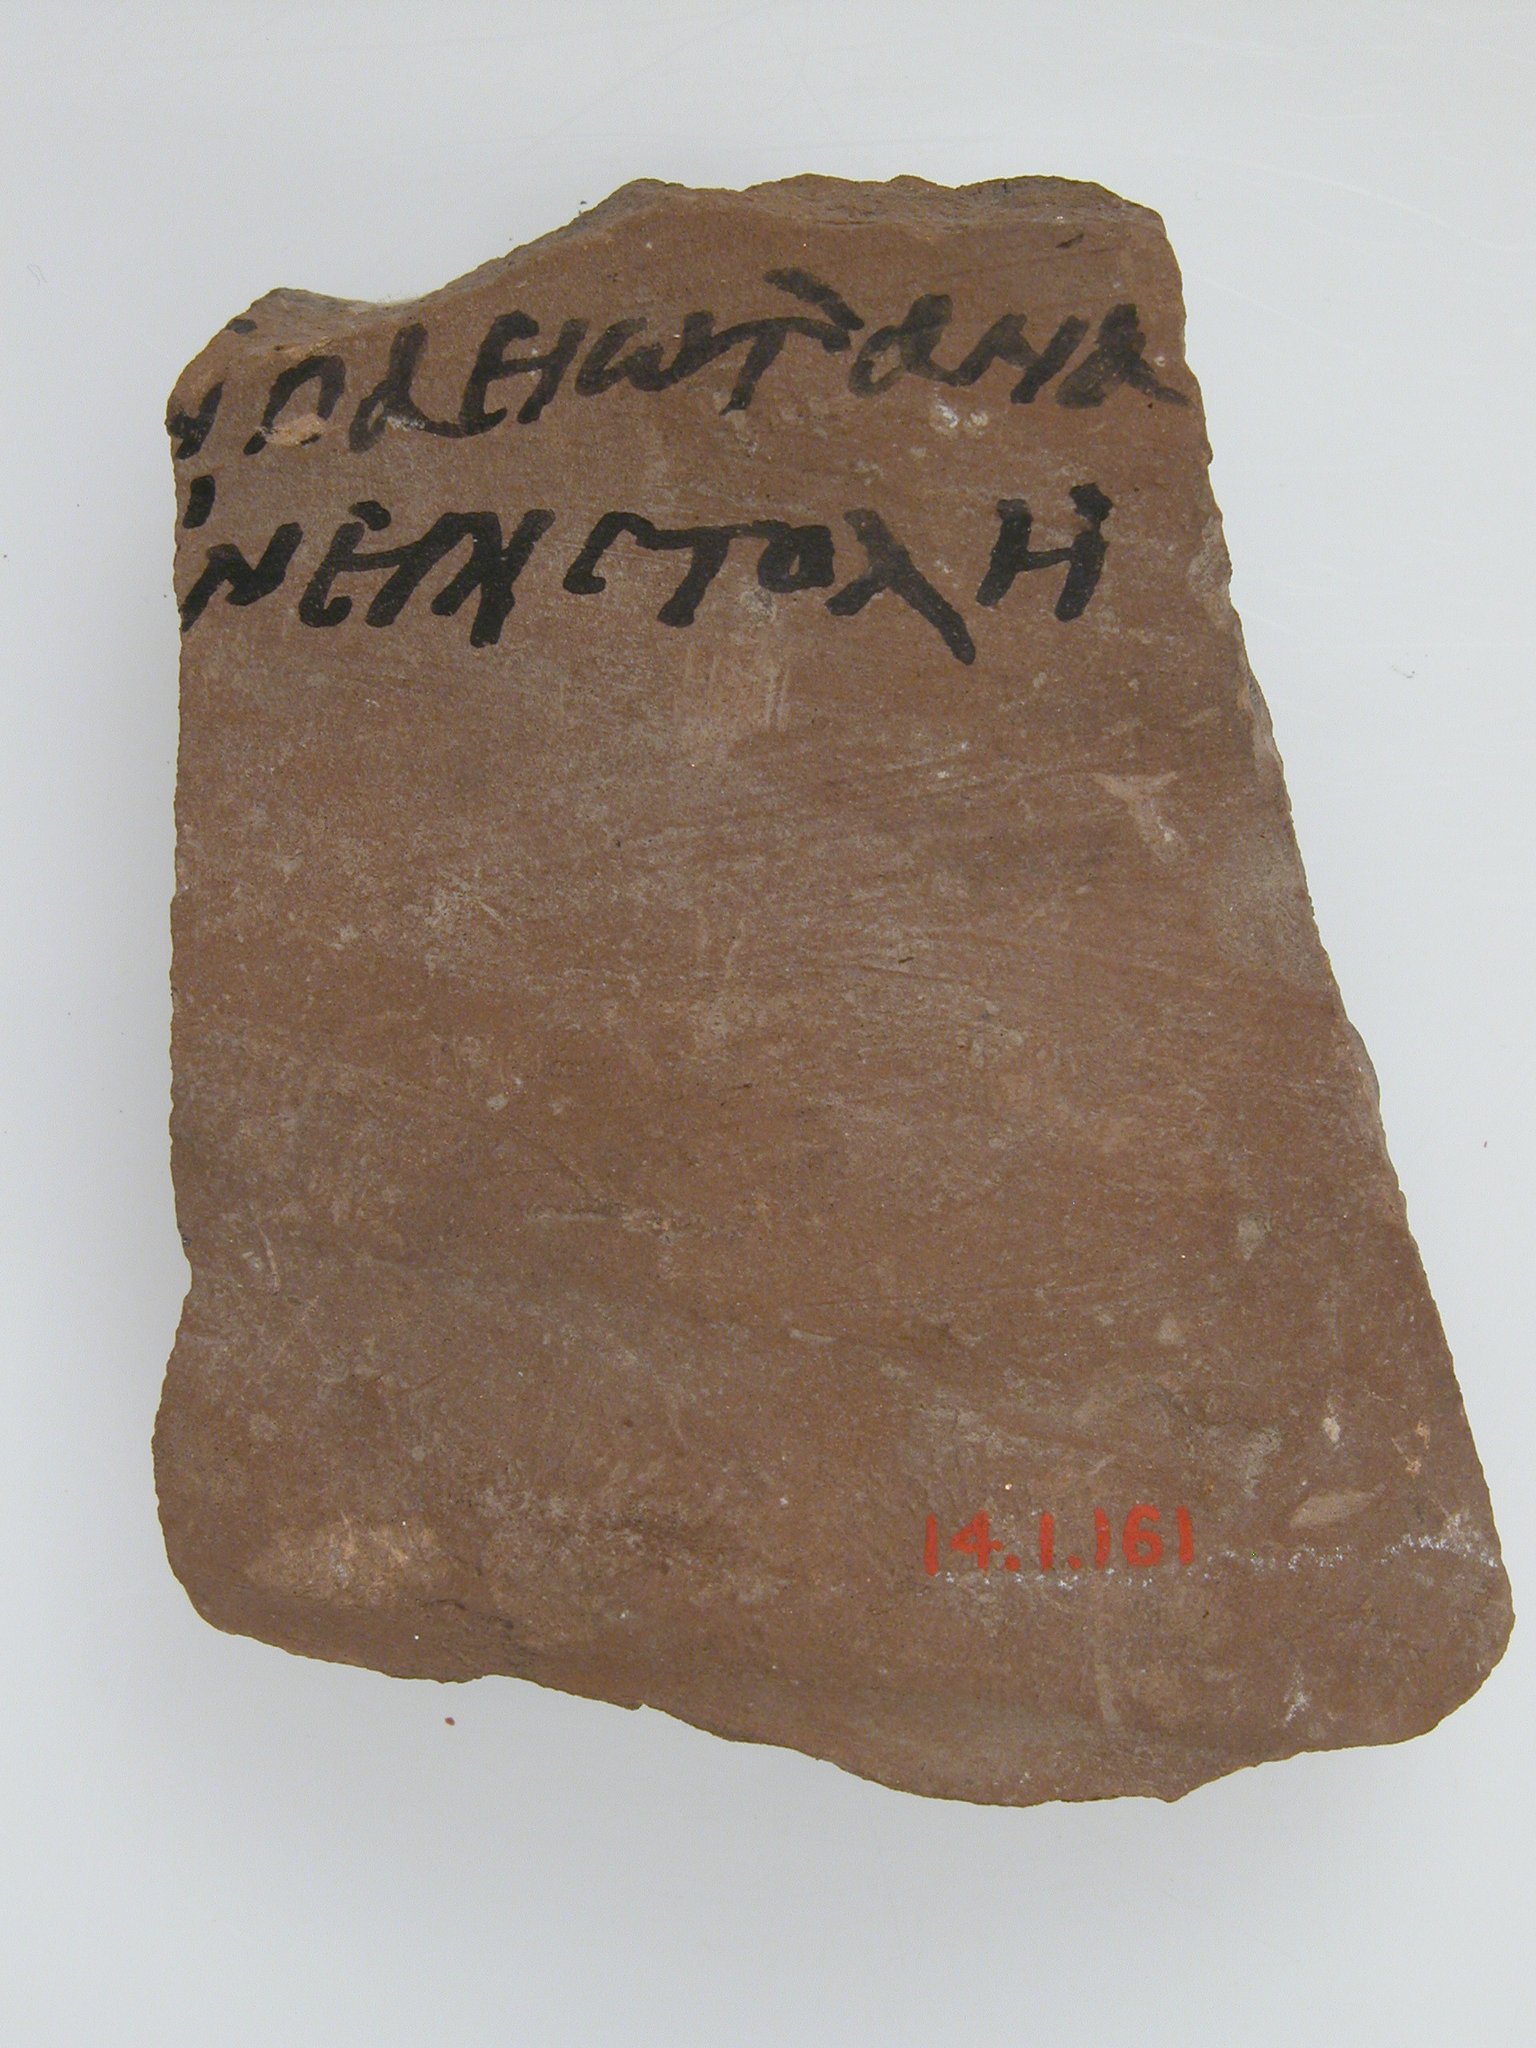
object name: ostrakon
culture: coptic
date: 600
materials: ink, pottery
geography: egypt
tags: coptic,documents